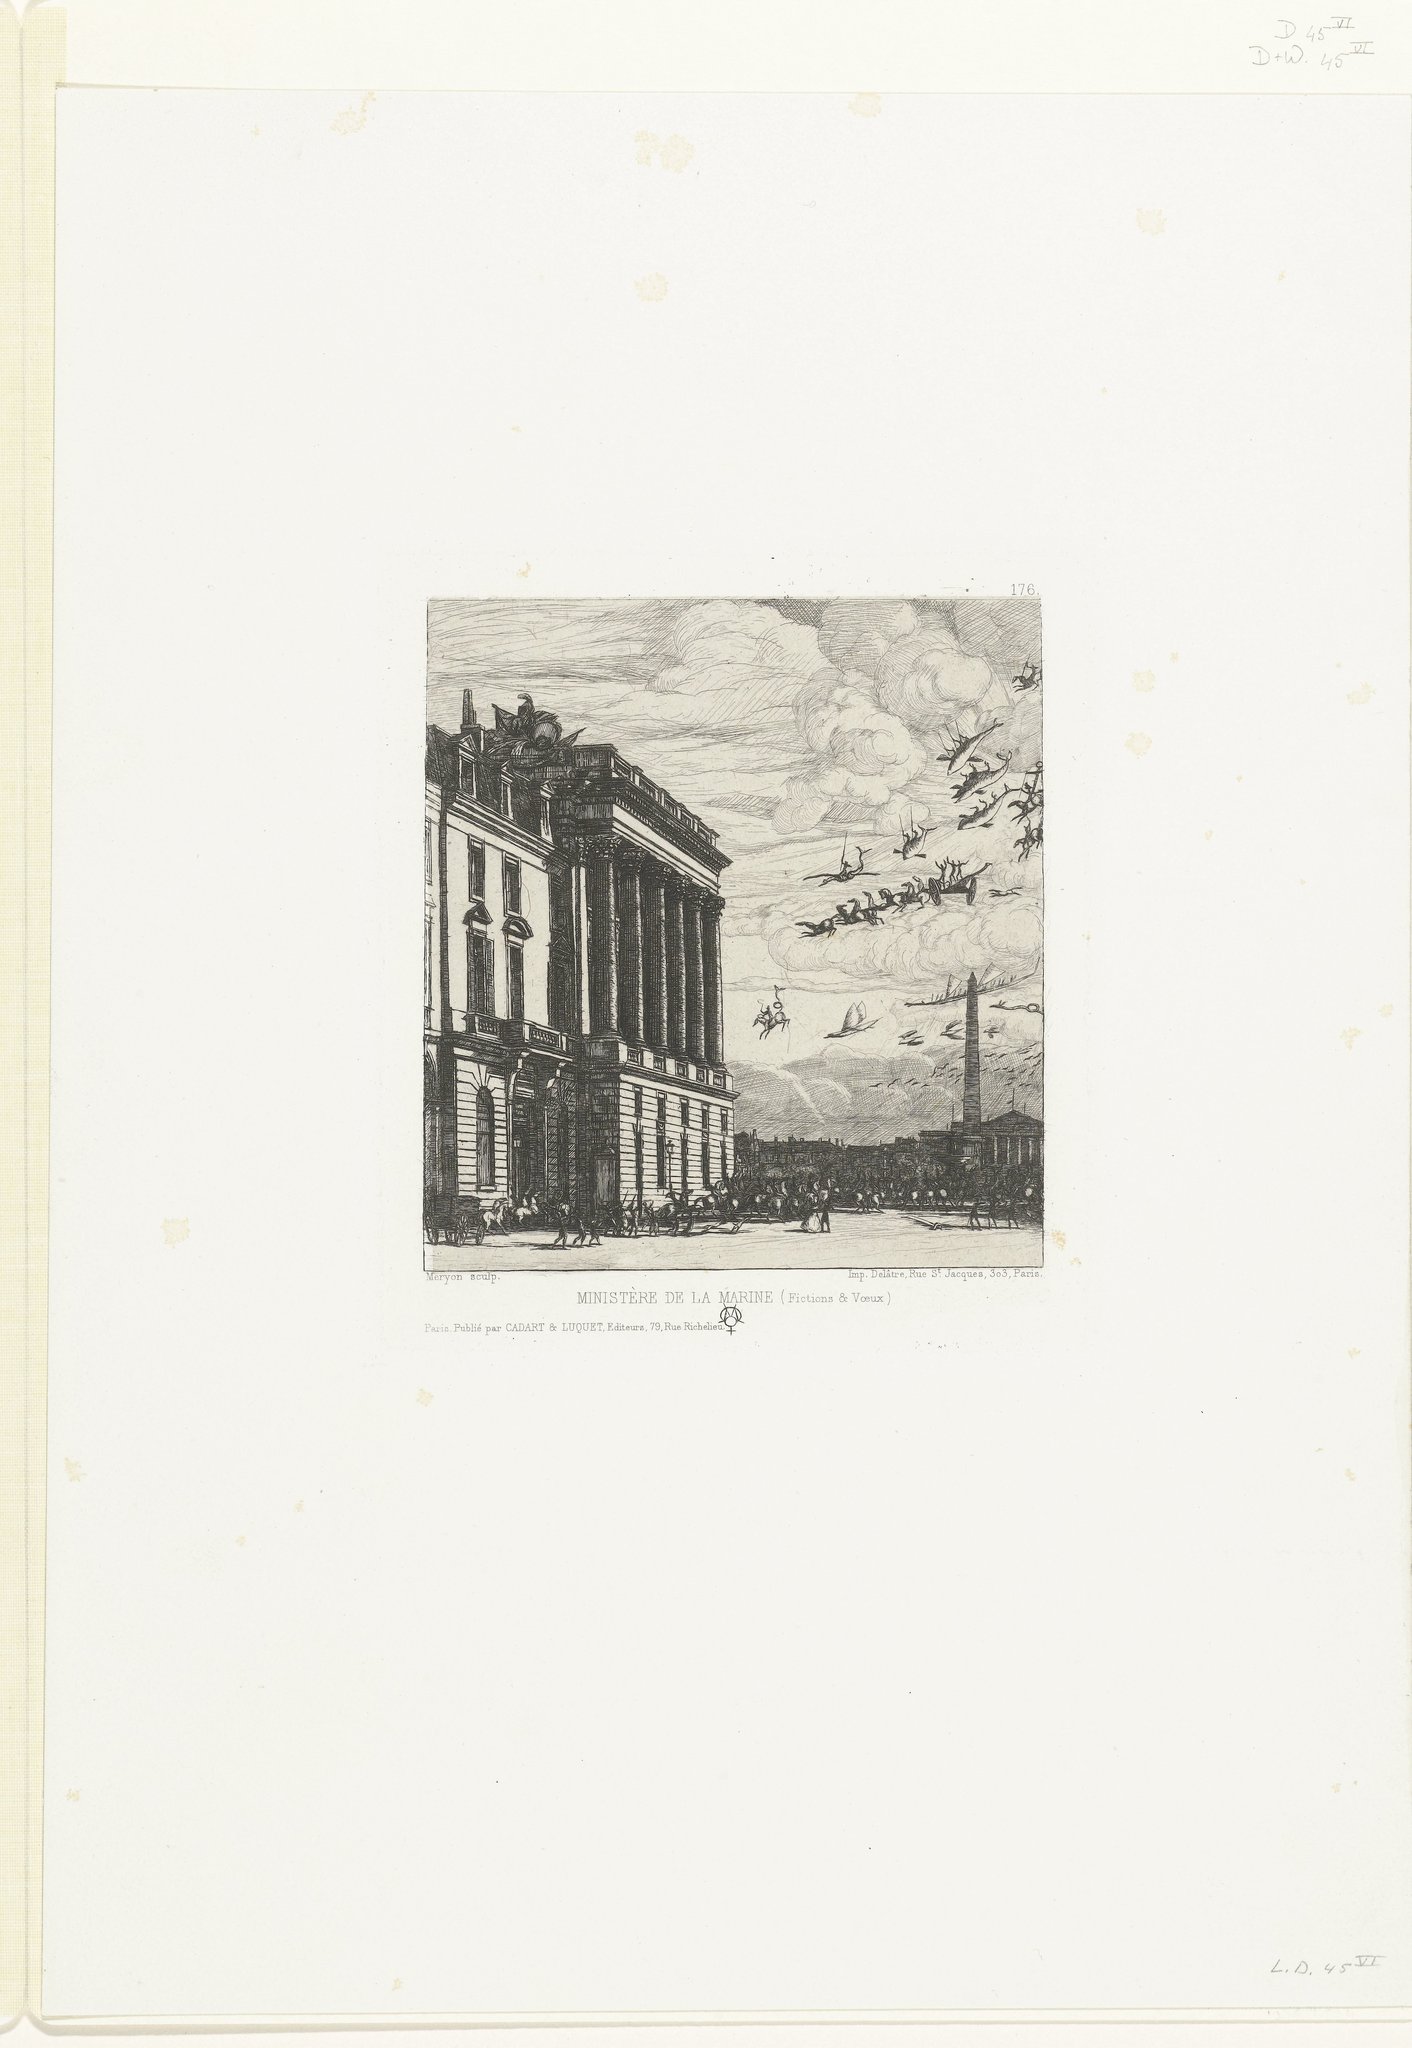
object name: print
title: Ministère de la Marine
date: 1865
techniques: printmaking, etching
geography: paris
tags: square, place, circus, etc., paris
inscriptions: collector's mark: Lugt 2228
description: Gezicht op het gebouw van het Ministerie van Marine, gezien vanaf de Rue Royale met in de verte rechts de obelisk op de Place de la Concorde in Parijs. In de lucht vliegen allerlei fantasie wezens zoals vissen en paarden die worden gadegeslagen door toeschouwers op het plein voor het ministerie.